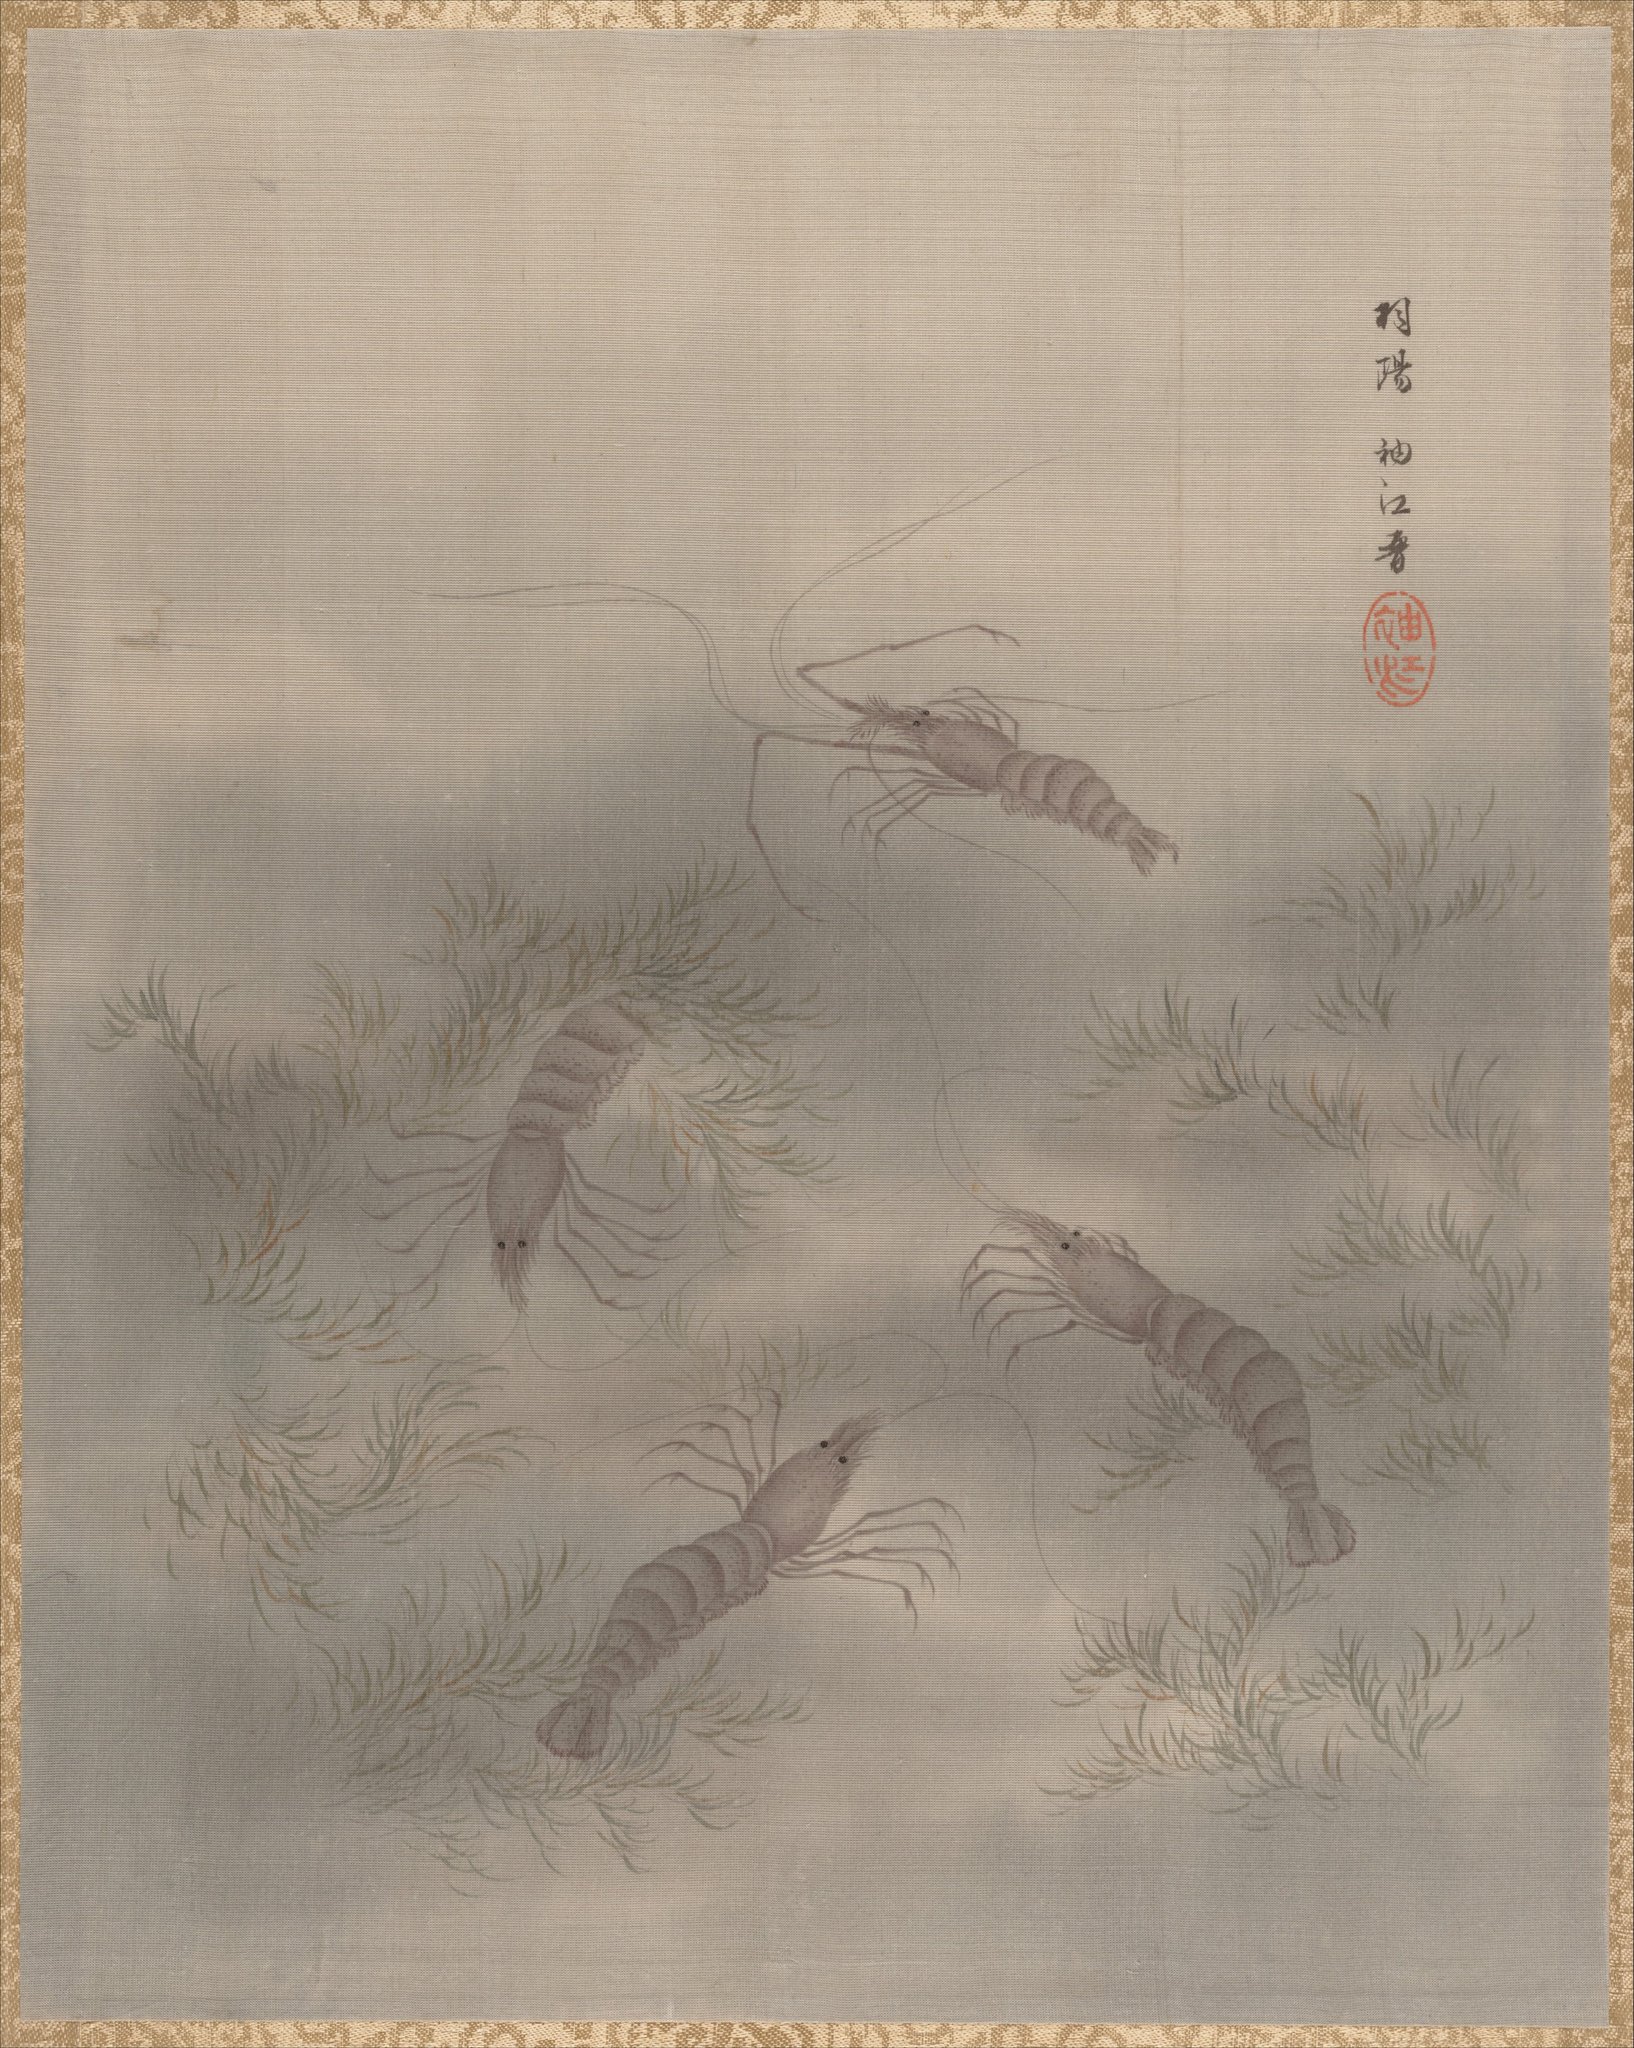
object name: album leaf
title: Shrimp (Ebi)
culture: japanese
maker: seki shūkō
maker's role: artist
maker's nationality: japanese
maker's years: 1858-1915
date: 1890-1892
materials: silk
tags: fish